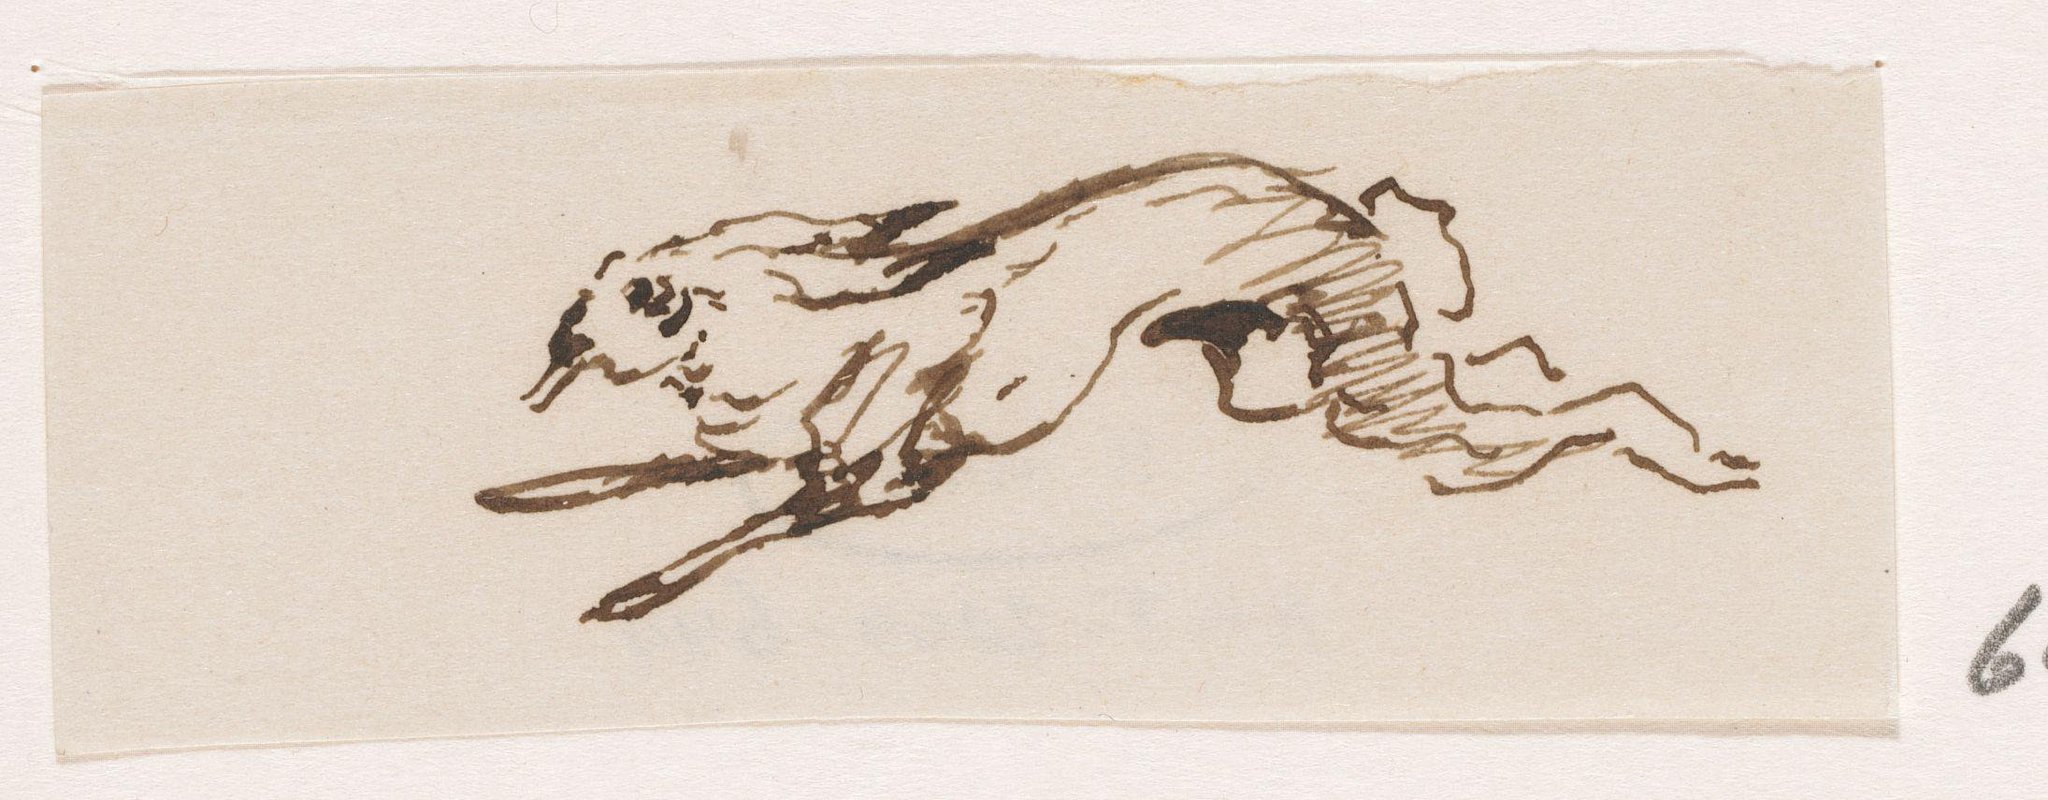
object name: drawing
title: Haas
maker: johannes tavenraat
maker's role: draughtsman, painter, print maker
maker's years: 1809-1881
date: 1840-1880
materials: ink, paper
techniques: pen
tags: rodents: hare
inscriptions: collector's mark: Lugt 2228